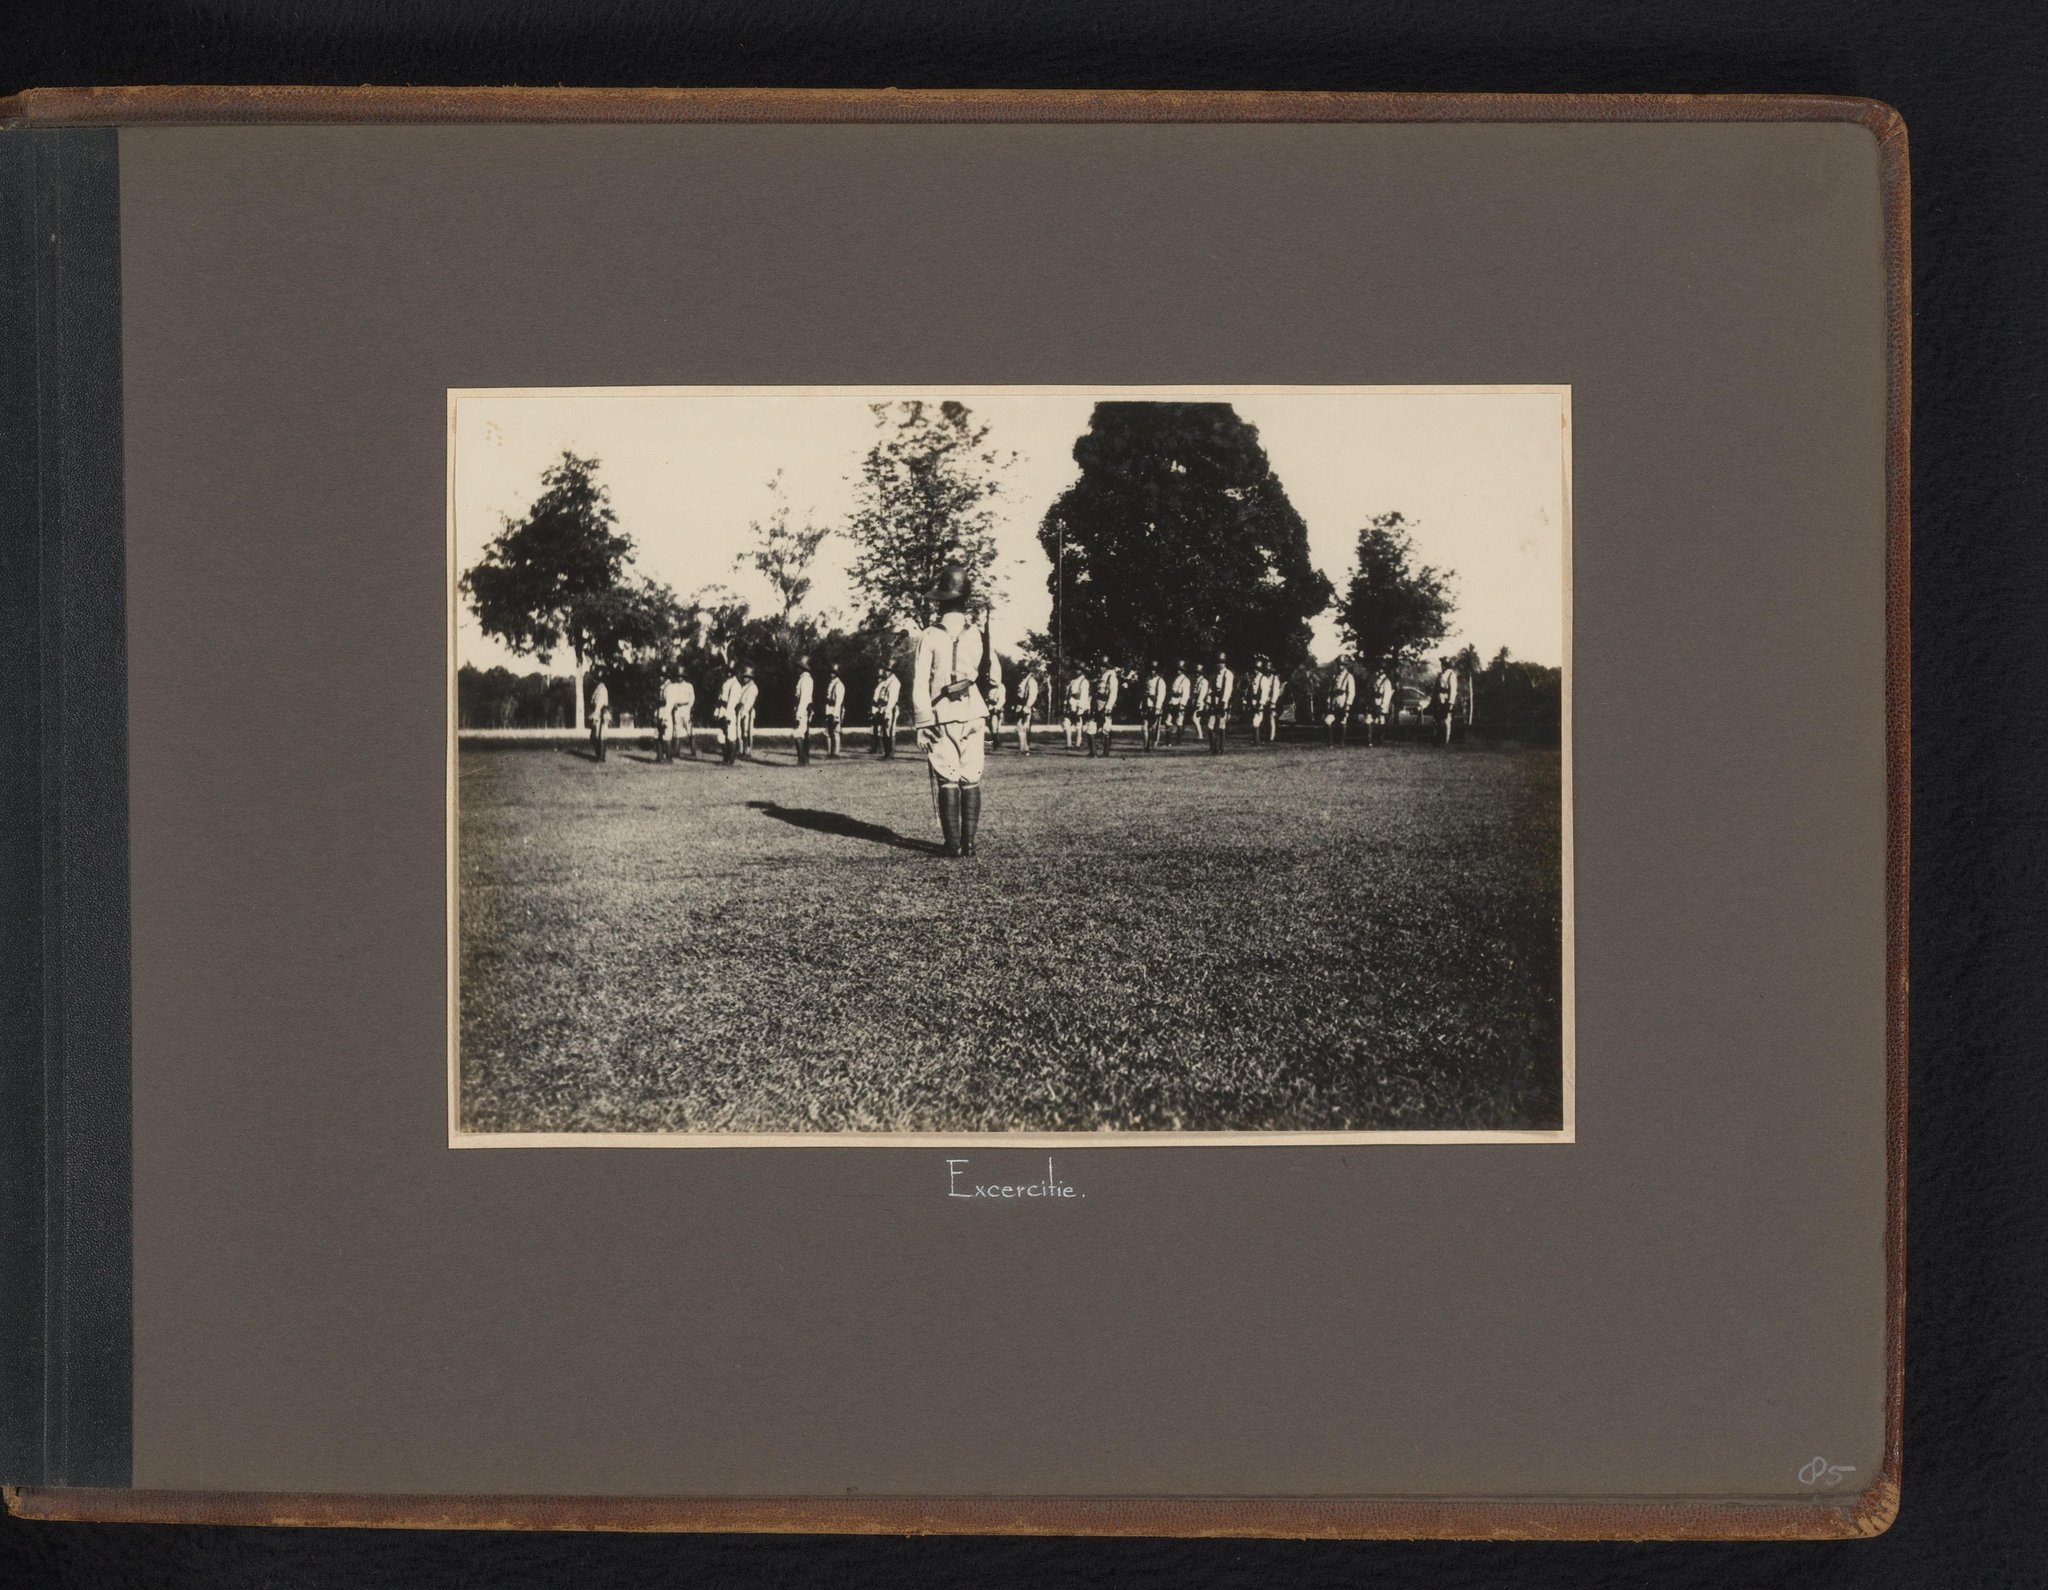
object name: photograph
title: Exercitie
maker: Anonymous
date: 1925-1931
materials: cardboard, photographic support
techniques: gelatin silver print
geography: aceh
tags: sumatra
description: Albumblad met één foto: exercitie door de politie van Atjeh. Onderdeel van het fotoalbum aangeboden aan S. Koster door de Vereeniging van Hoogere Politie Ambtenaren in Nederlandsch-Indië in 1931.